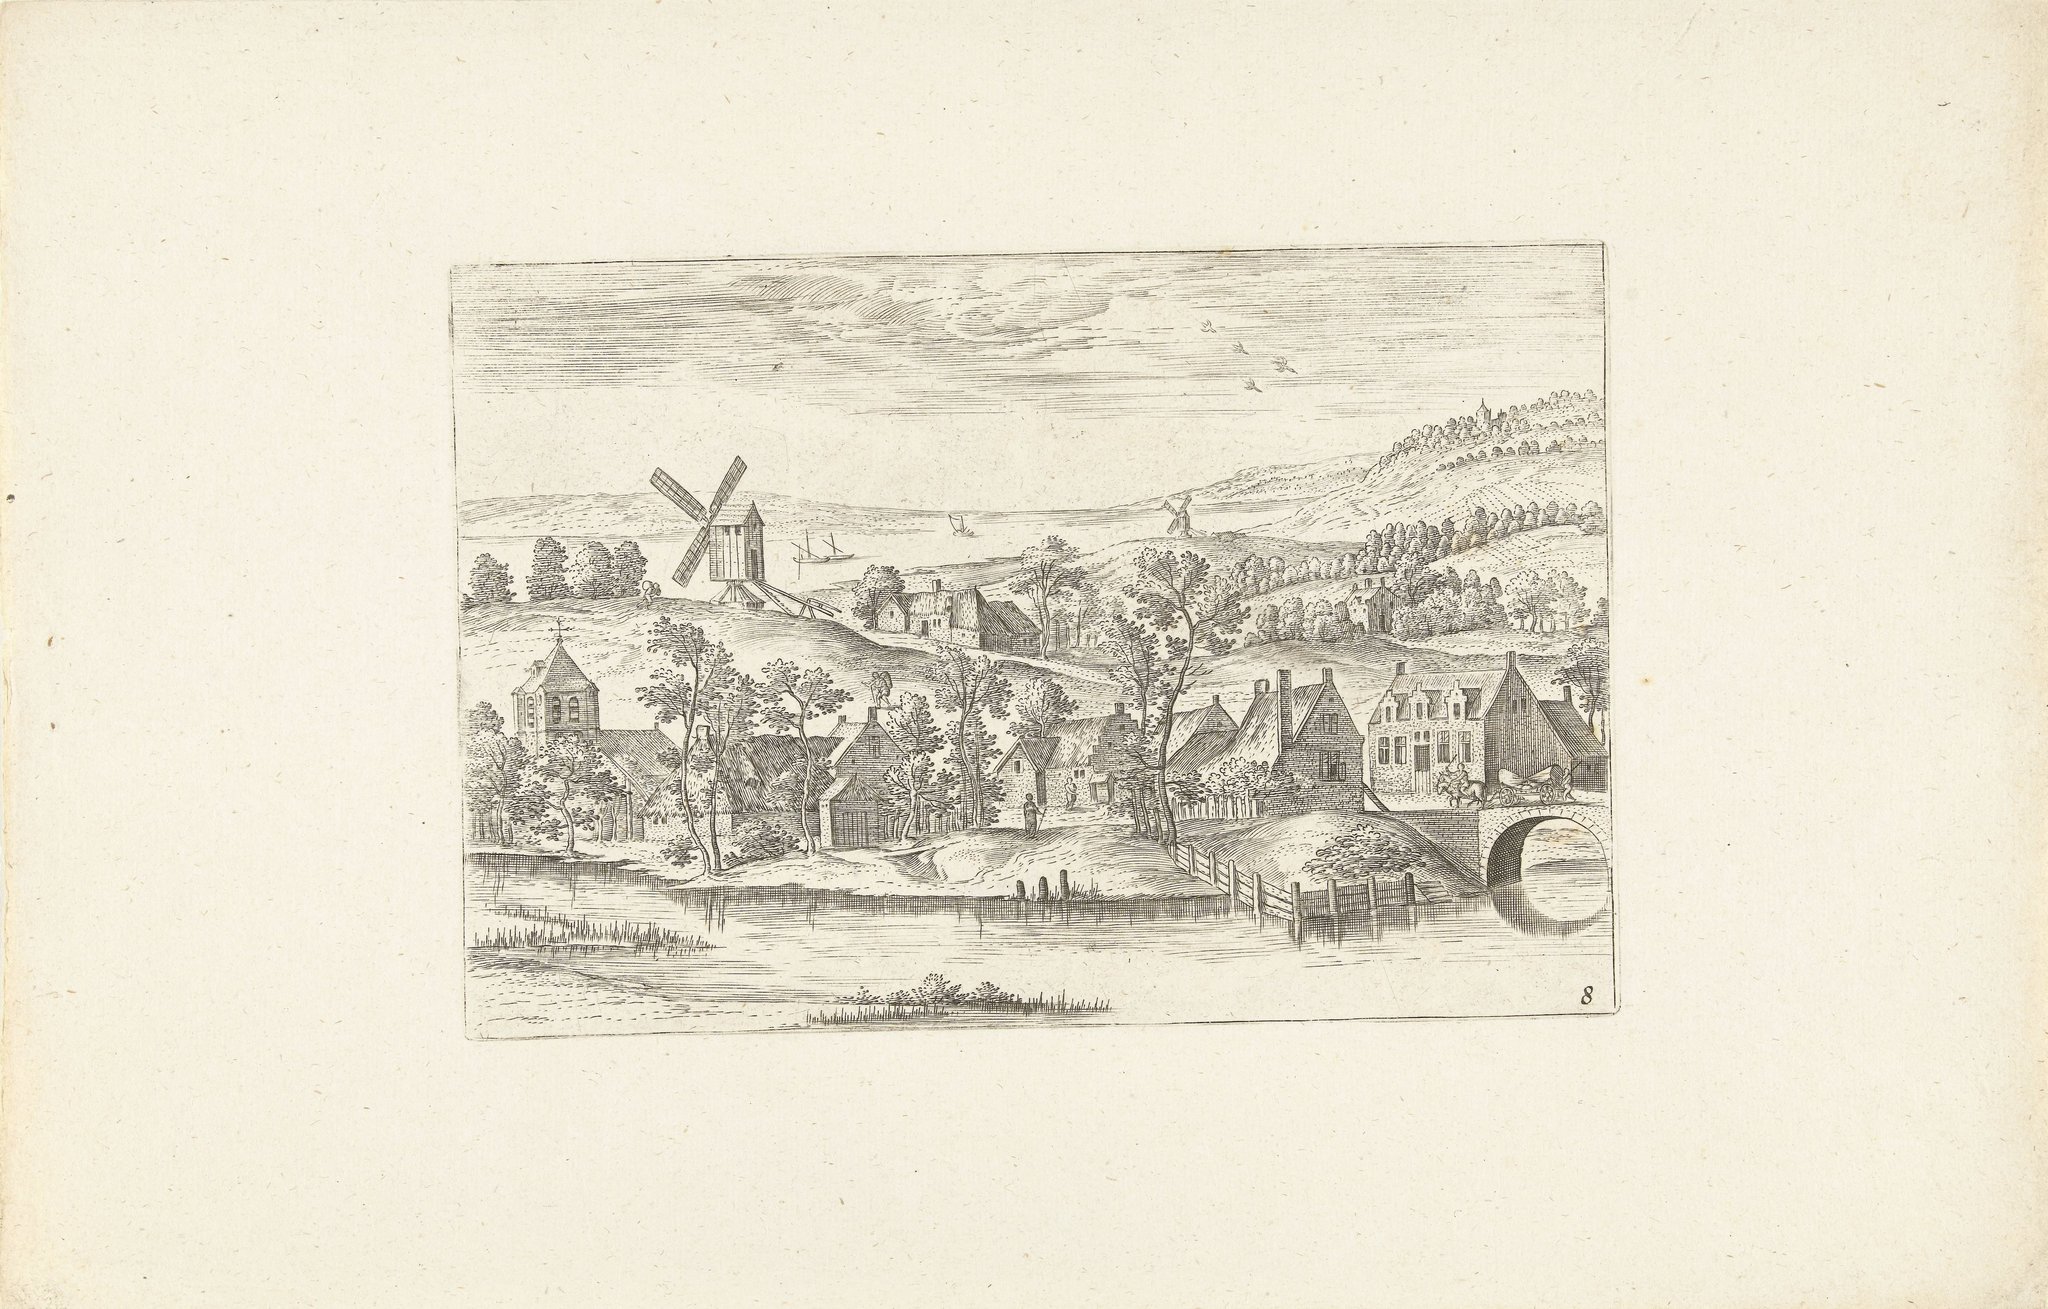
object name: print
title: Landschap met een rivier en een windmolen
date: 1578-1618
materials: paper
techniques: engraving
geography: amsterdam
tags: river bank (+ landscape with figures, staffage), windmill in landscape (+ city(-scape) with figures, staffage)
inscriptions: collector's mark: Lugt 2233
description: Landschap met een rivier en een dorpje. Op de achtergrond een heuvel met een windmolen. De prent is deel van een twaalfdelige serie met landschappen rond Antwerpen.